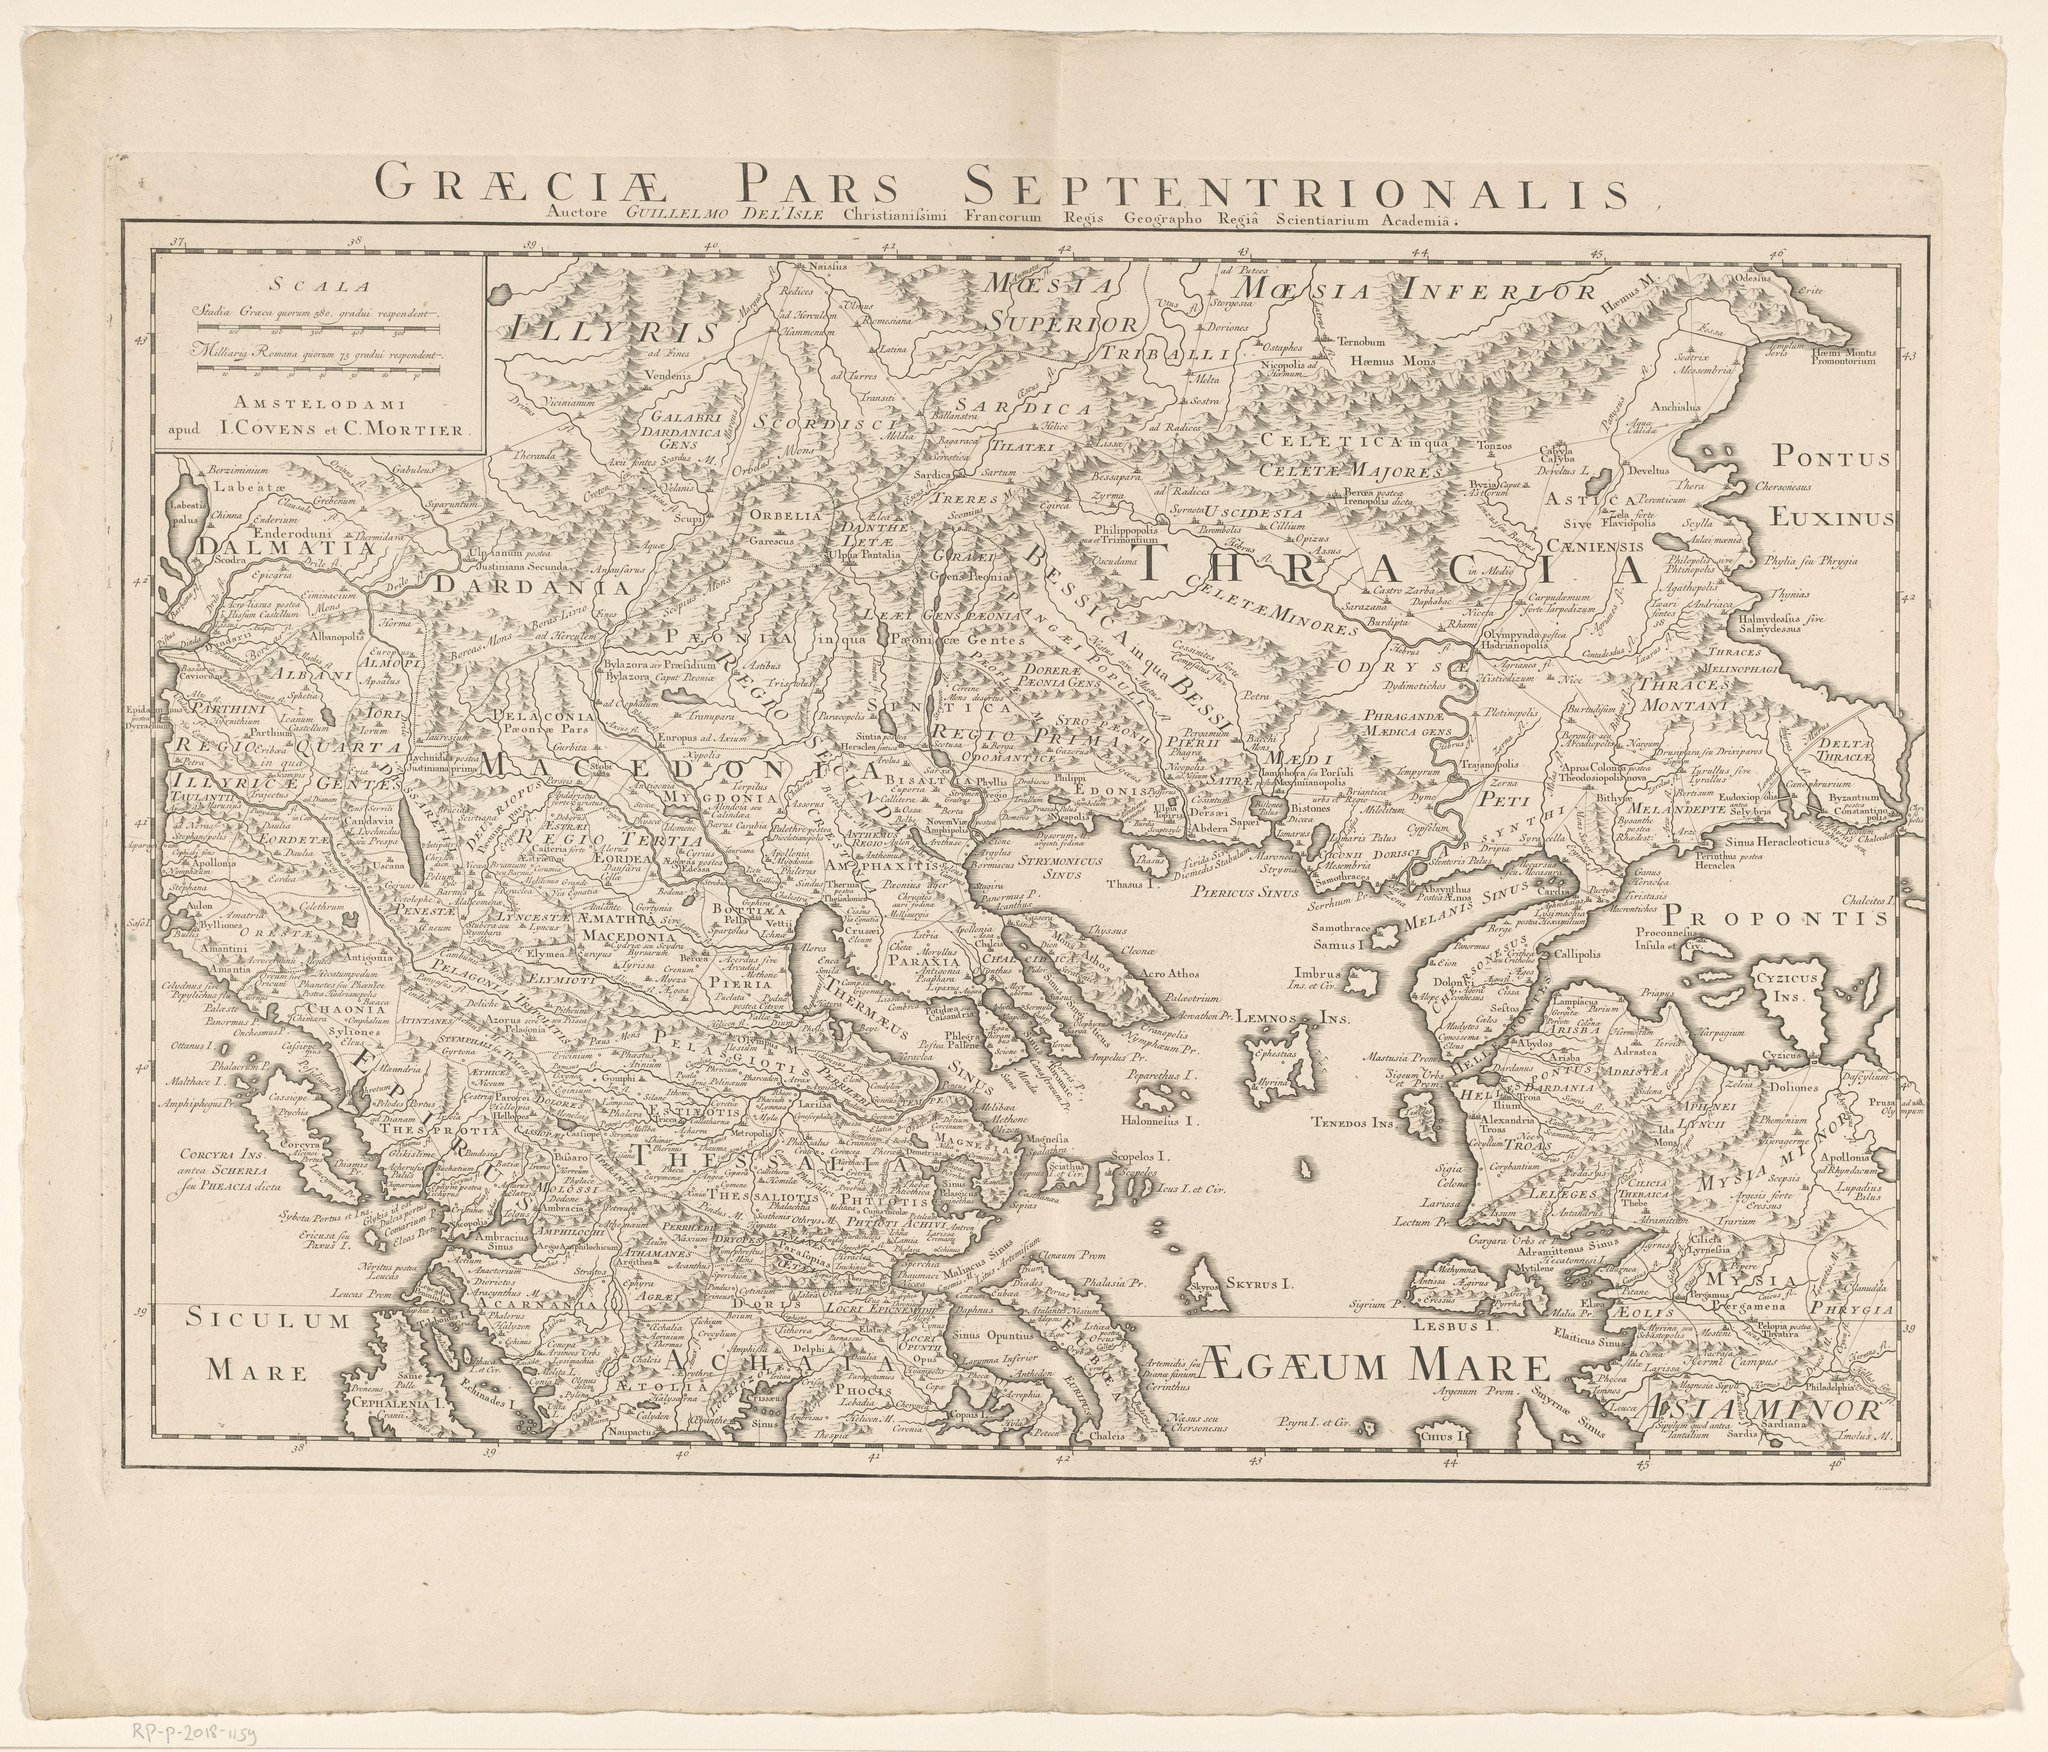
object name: map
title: Graeciae pars septentrionalis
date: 1721-1774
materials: paper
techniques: engraving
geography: amsterdam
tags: maps of separate countries or regions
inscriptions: collector's mark: Lugt 1641a, collector's mark: Lugt 2228